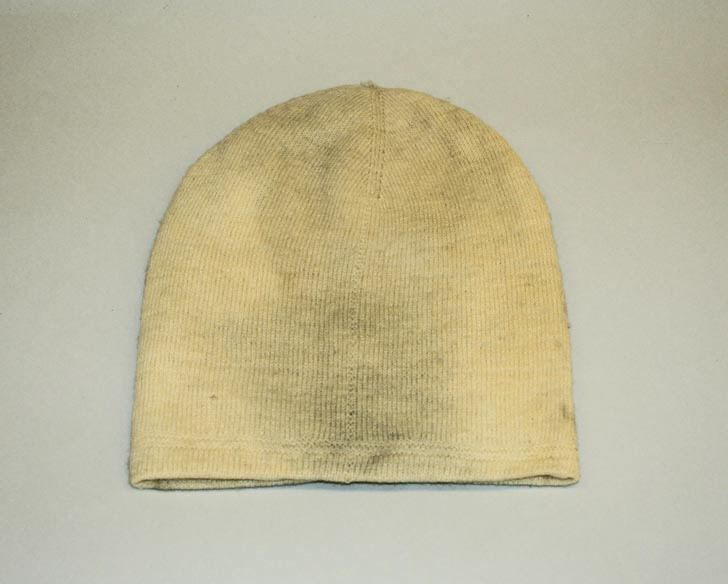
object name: nightcap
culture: british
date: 1801-1833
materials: wool